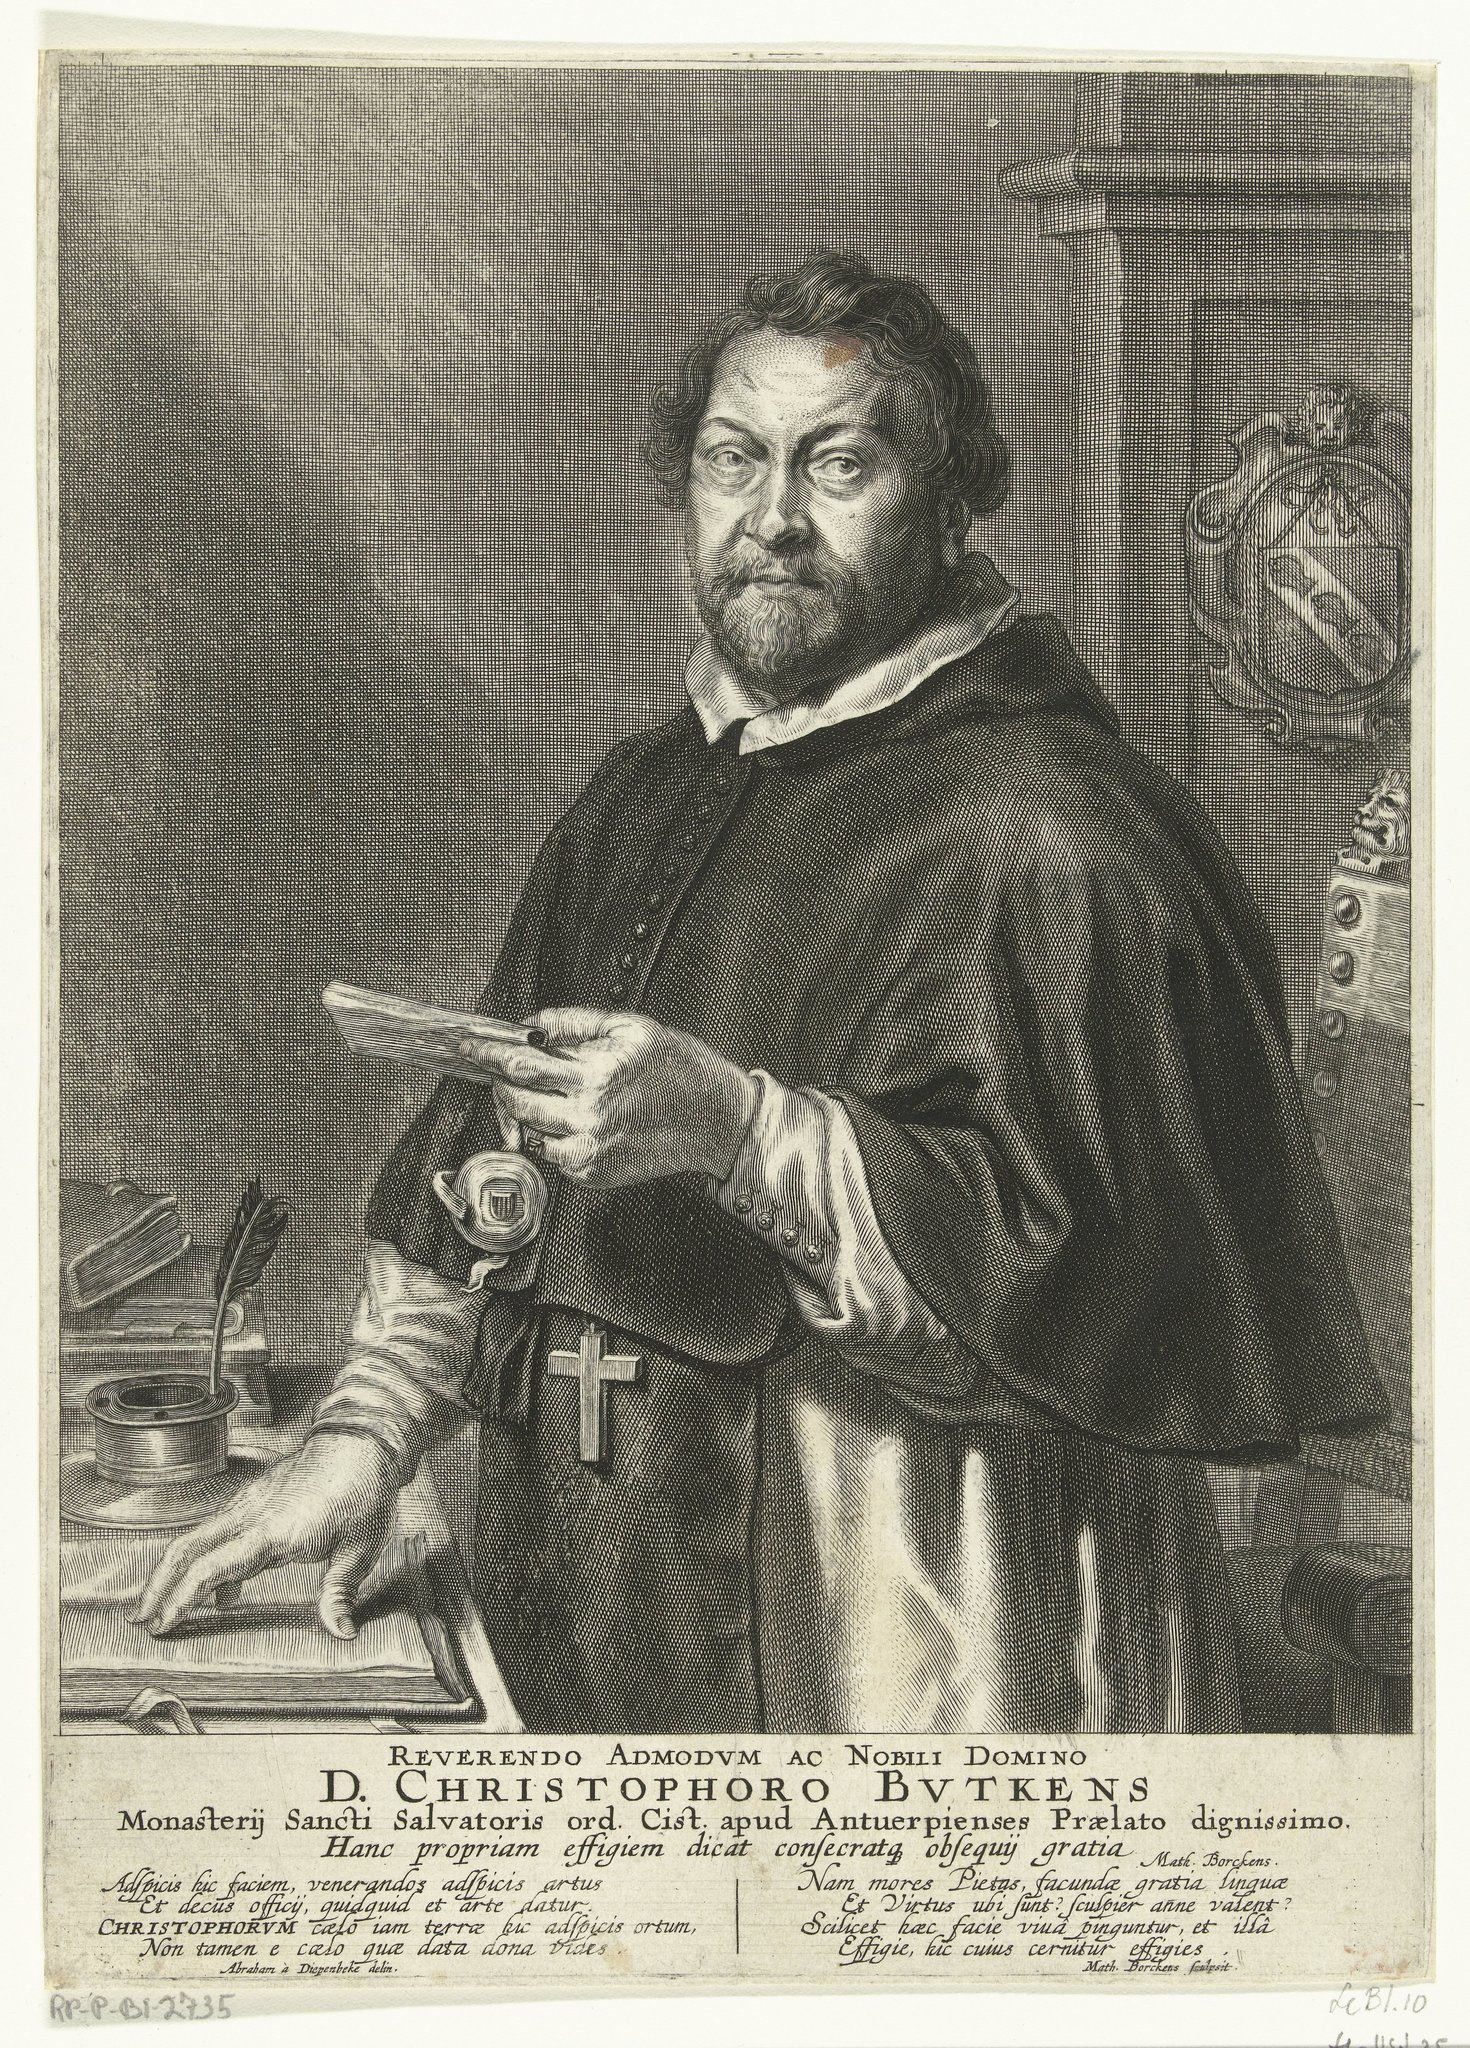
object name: print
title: Portret van Christoph Butkens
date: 1644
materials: paper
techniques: engraving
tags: antwerp, the hague, christophorus butkens, coat of arms (as symbol of the state, etc.), theologian in his study (writing or reading)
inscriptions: collector's mark: Lugt 2228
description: Portret van Christophe Butkens, prior van het Salvatorklooster te Antwerpen. Hij draagt het habijt van de cisterciënzers. In zijn linkerhand houdt hij een brief met een zegel vast. Zijn rechterhand rust op een bureau met boeken en schrijfmateriaal, symbool voor zijn grote eruditie. Achter hem rechts een wapenschild. De prent heeft een Latijns onderschrift.